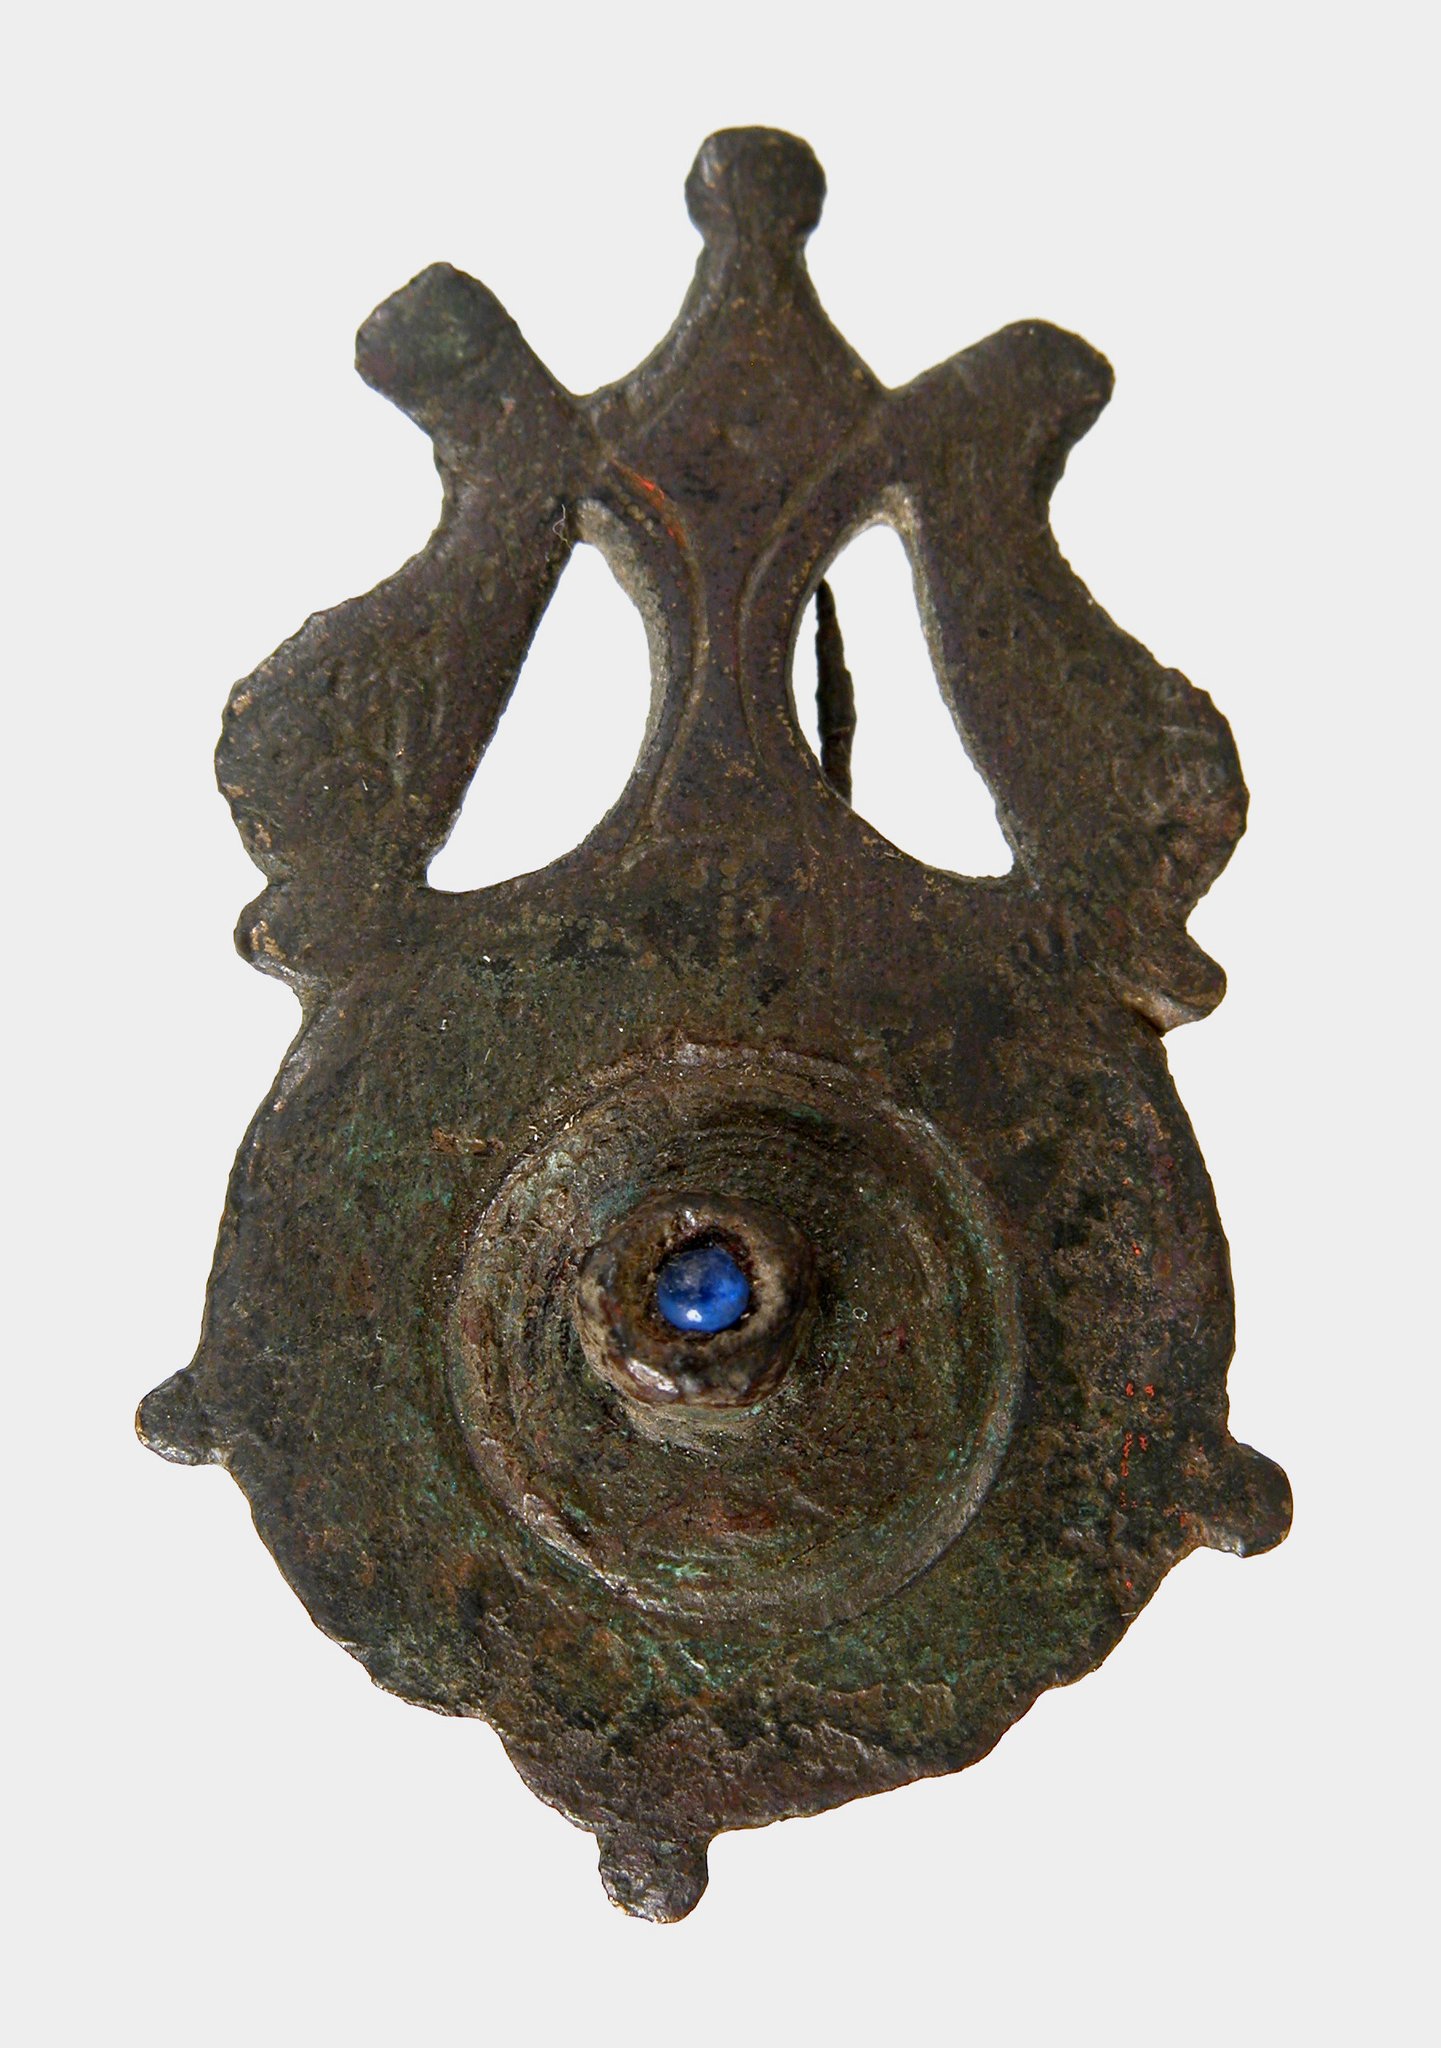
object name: brooch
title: Flat Brooch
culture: roman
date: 201-300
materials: copper alloy, glass